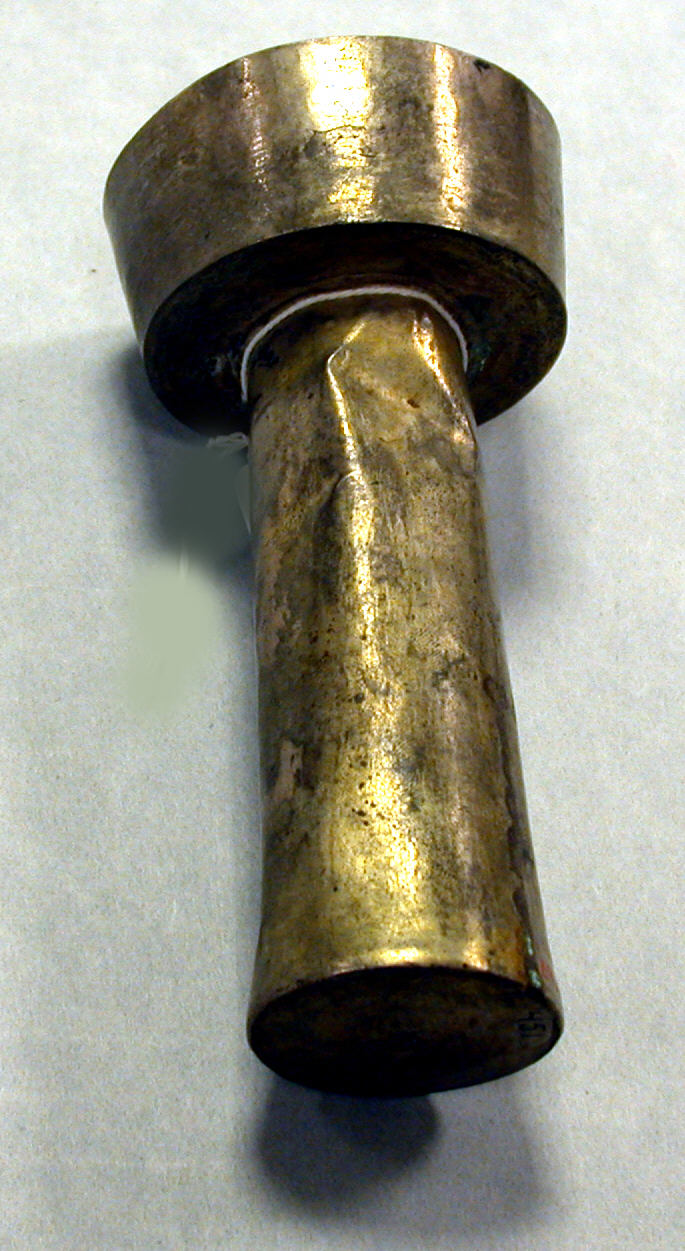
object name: rattle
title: Hammered Silver Rattle Beaker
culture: peruvian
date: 701-1566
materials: gilt, silver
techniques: hammering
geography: peru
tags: musical instruments